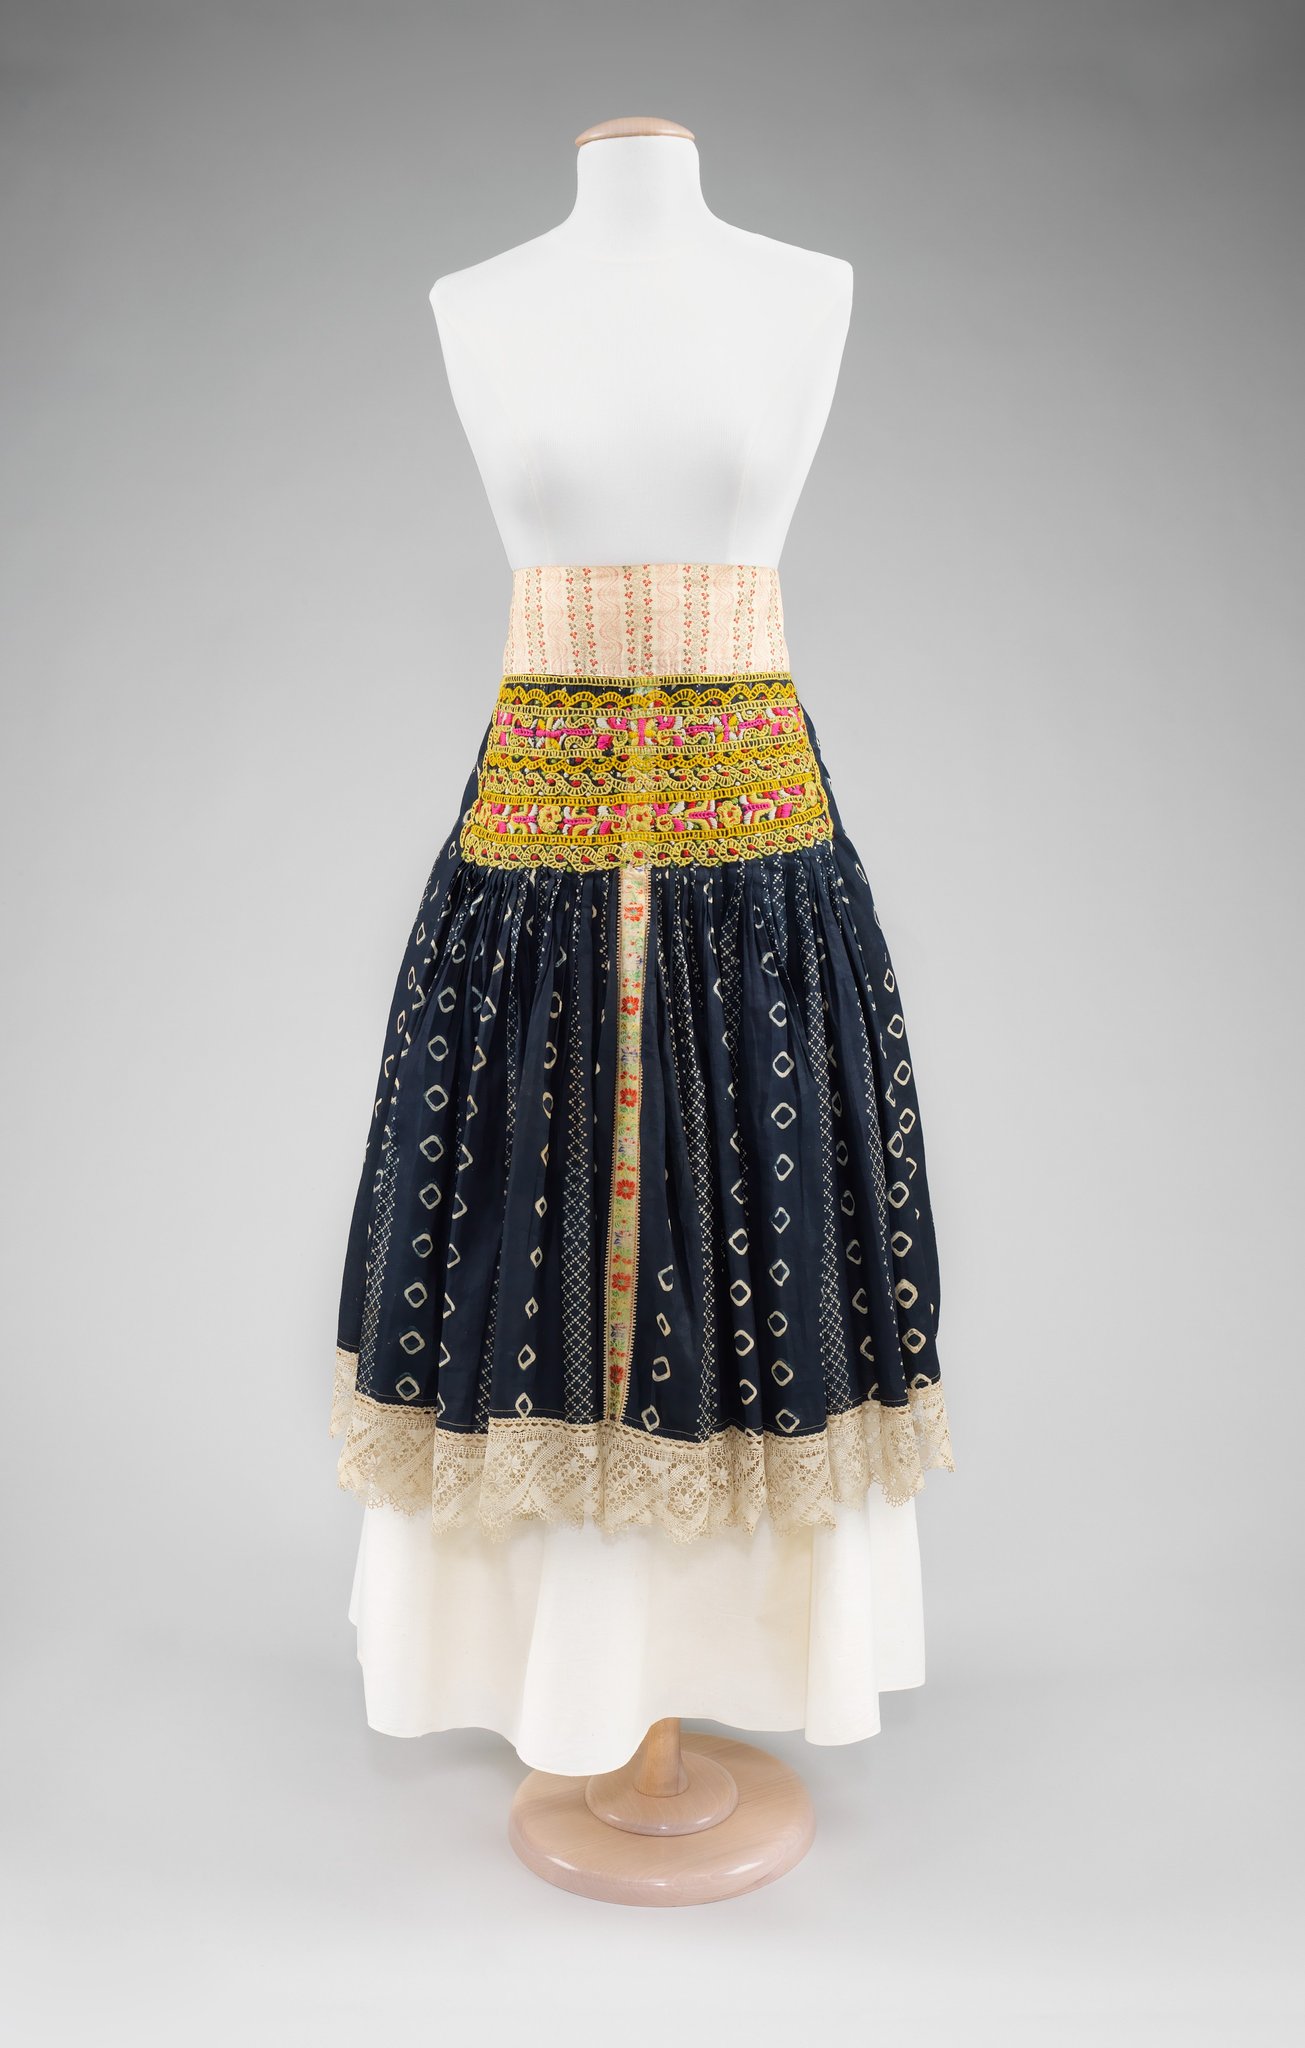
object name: apron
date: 1876-1900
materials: cotton, silk, wool